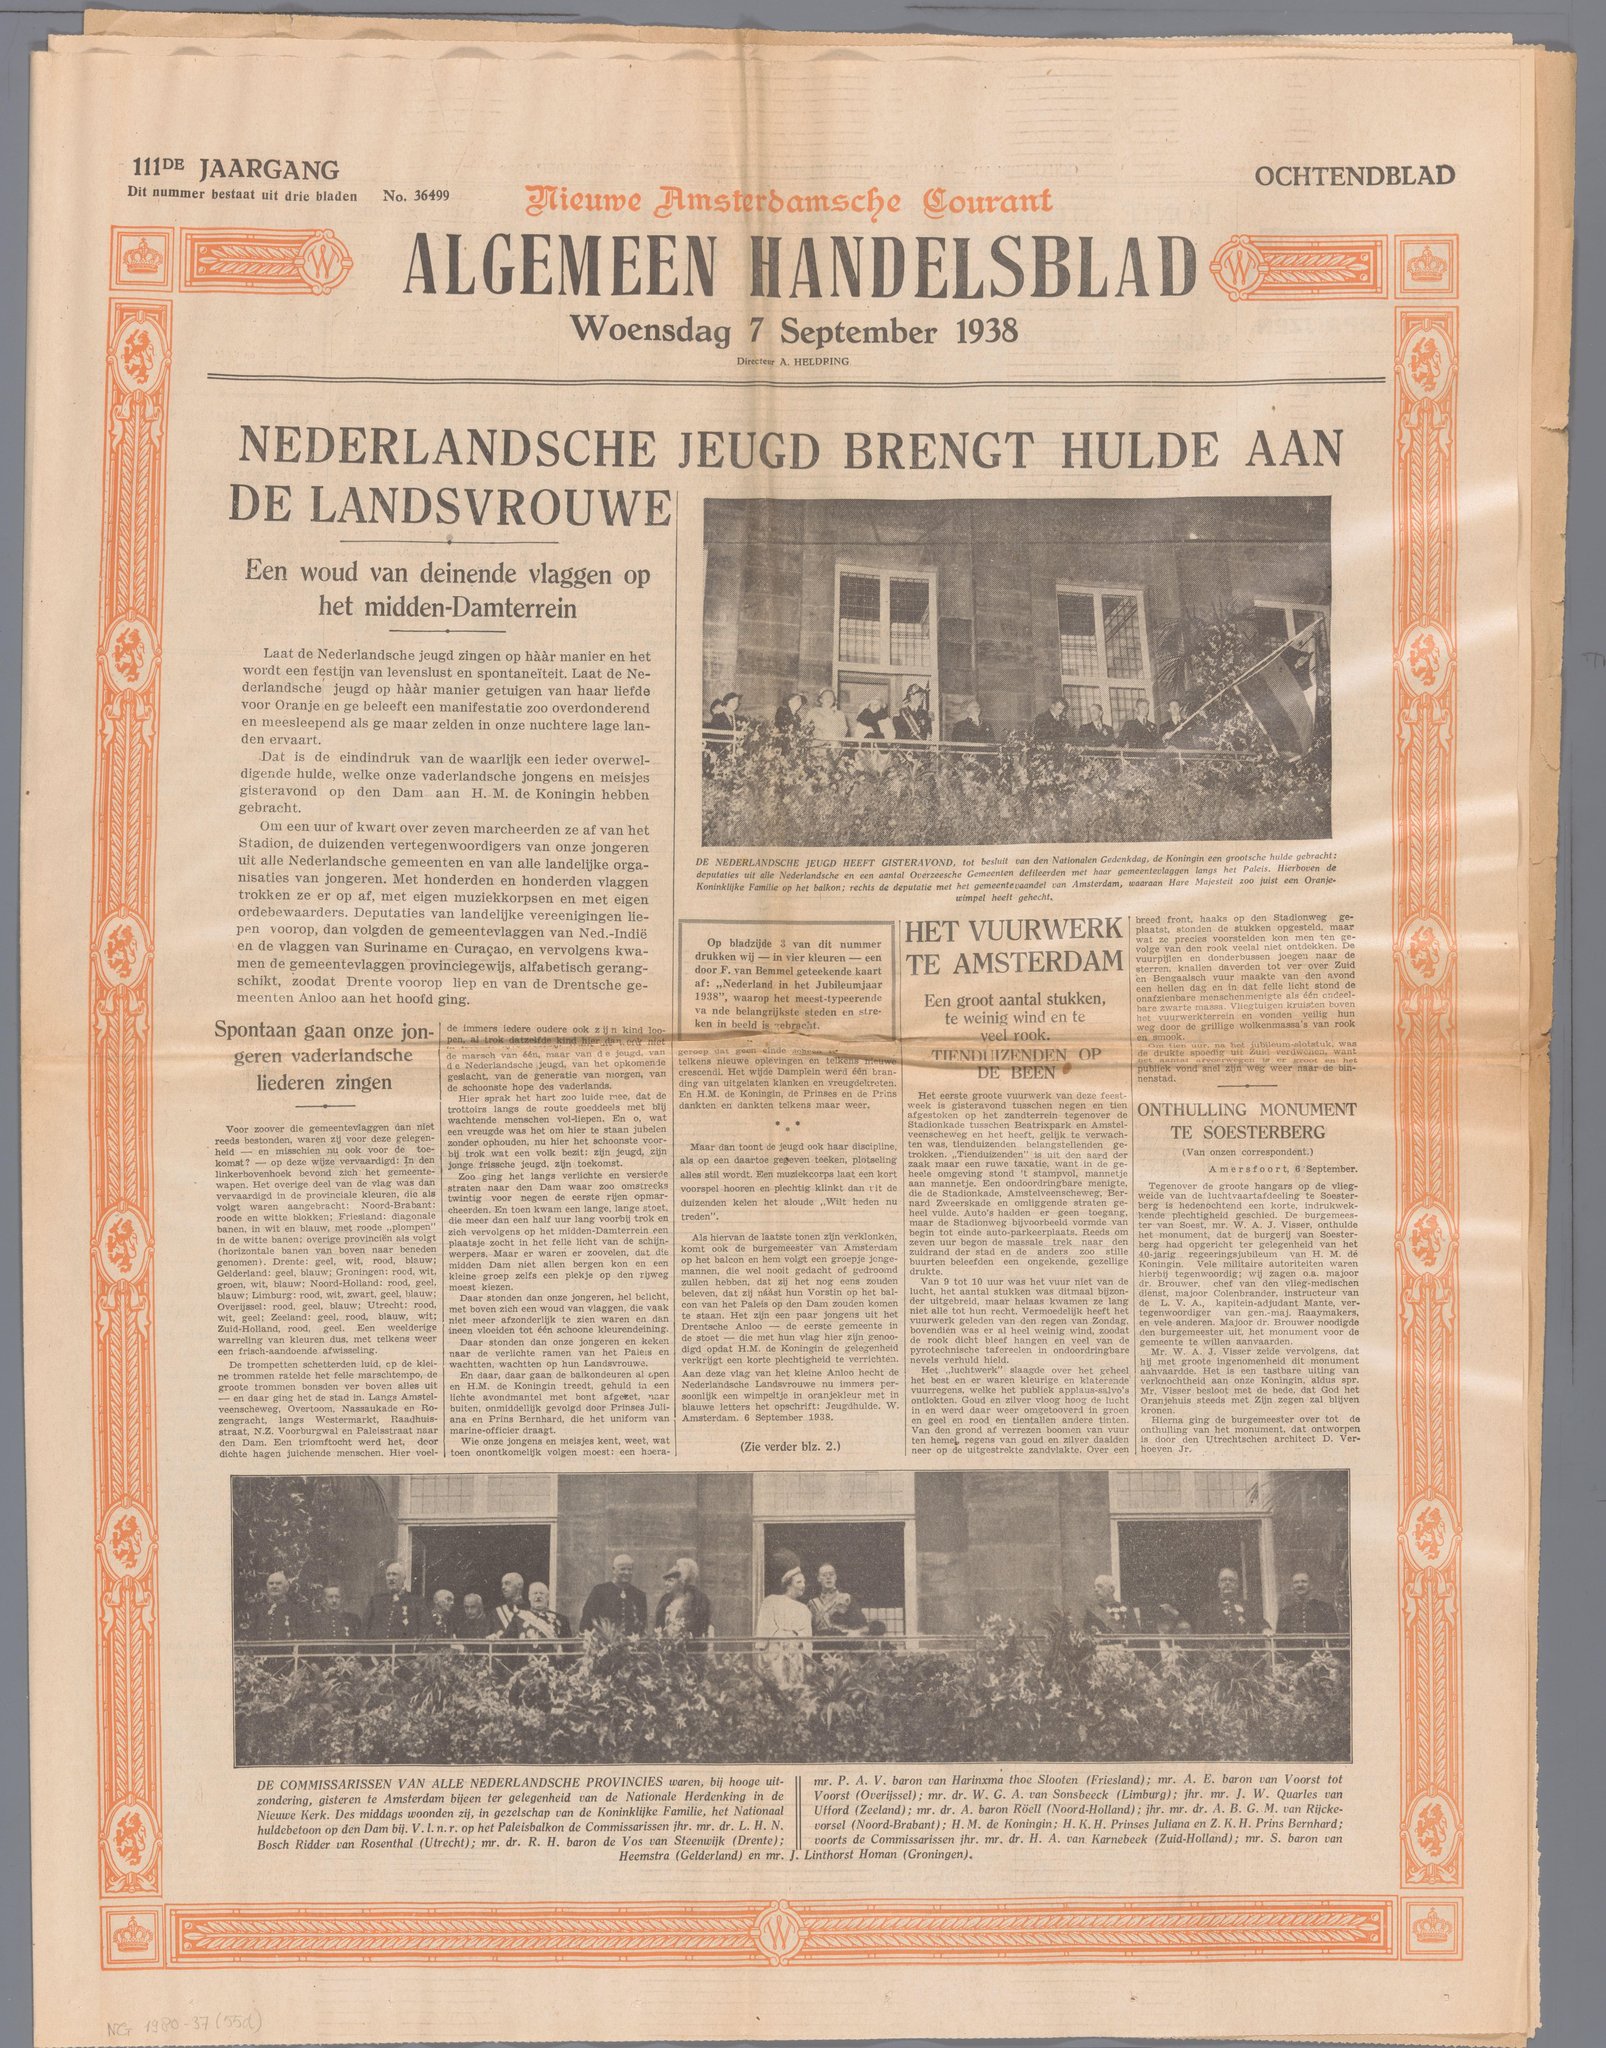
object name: newspaper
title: Wilhelmina Regina / Algemeen Handelsblad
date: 1938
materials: paper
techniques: printing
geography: amsterdam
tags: the hague, print maker, wilhelmina of the netherlands, netherlands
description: Krant. Algemeen Handelsblad 111 jaargang, bijvoegsel nr. 36499, voorpagina in oranje omlijsting, 10 genummerde pp.